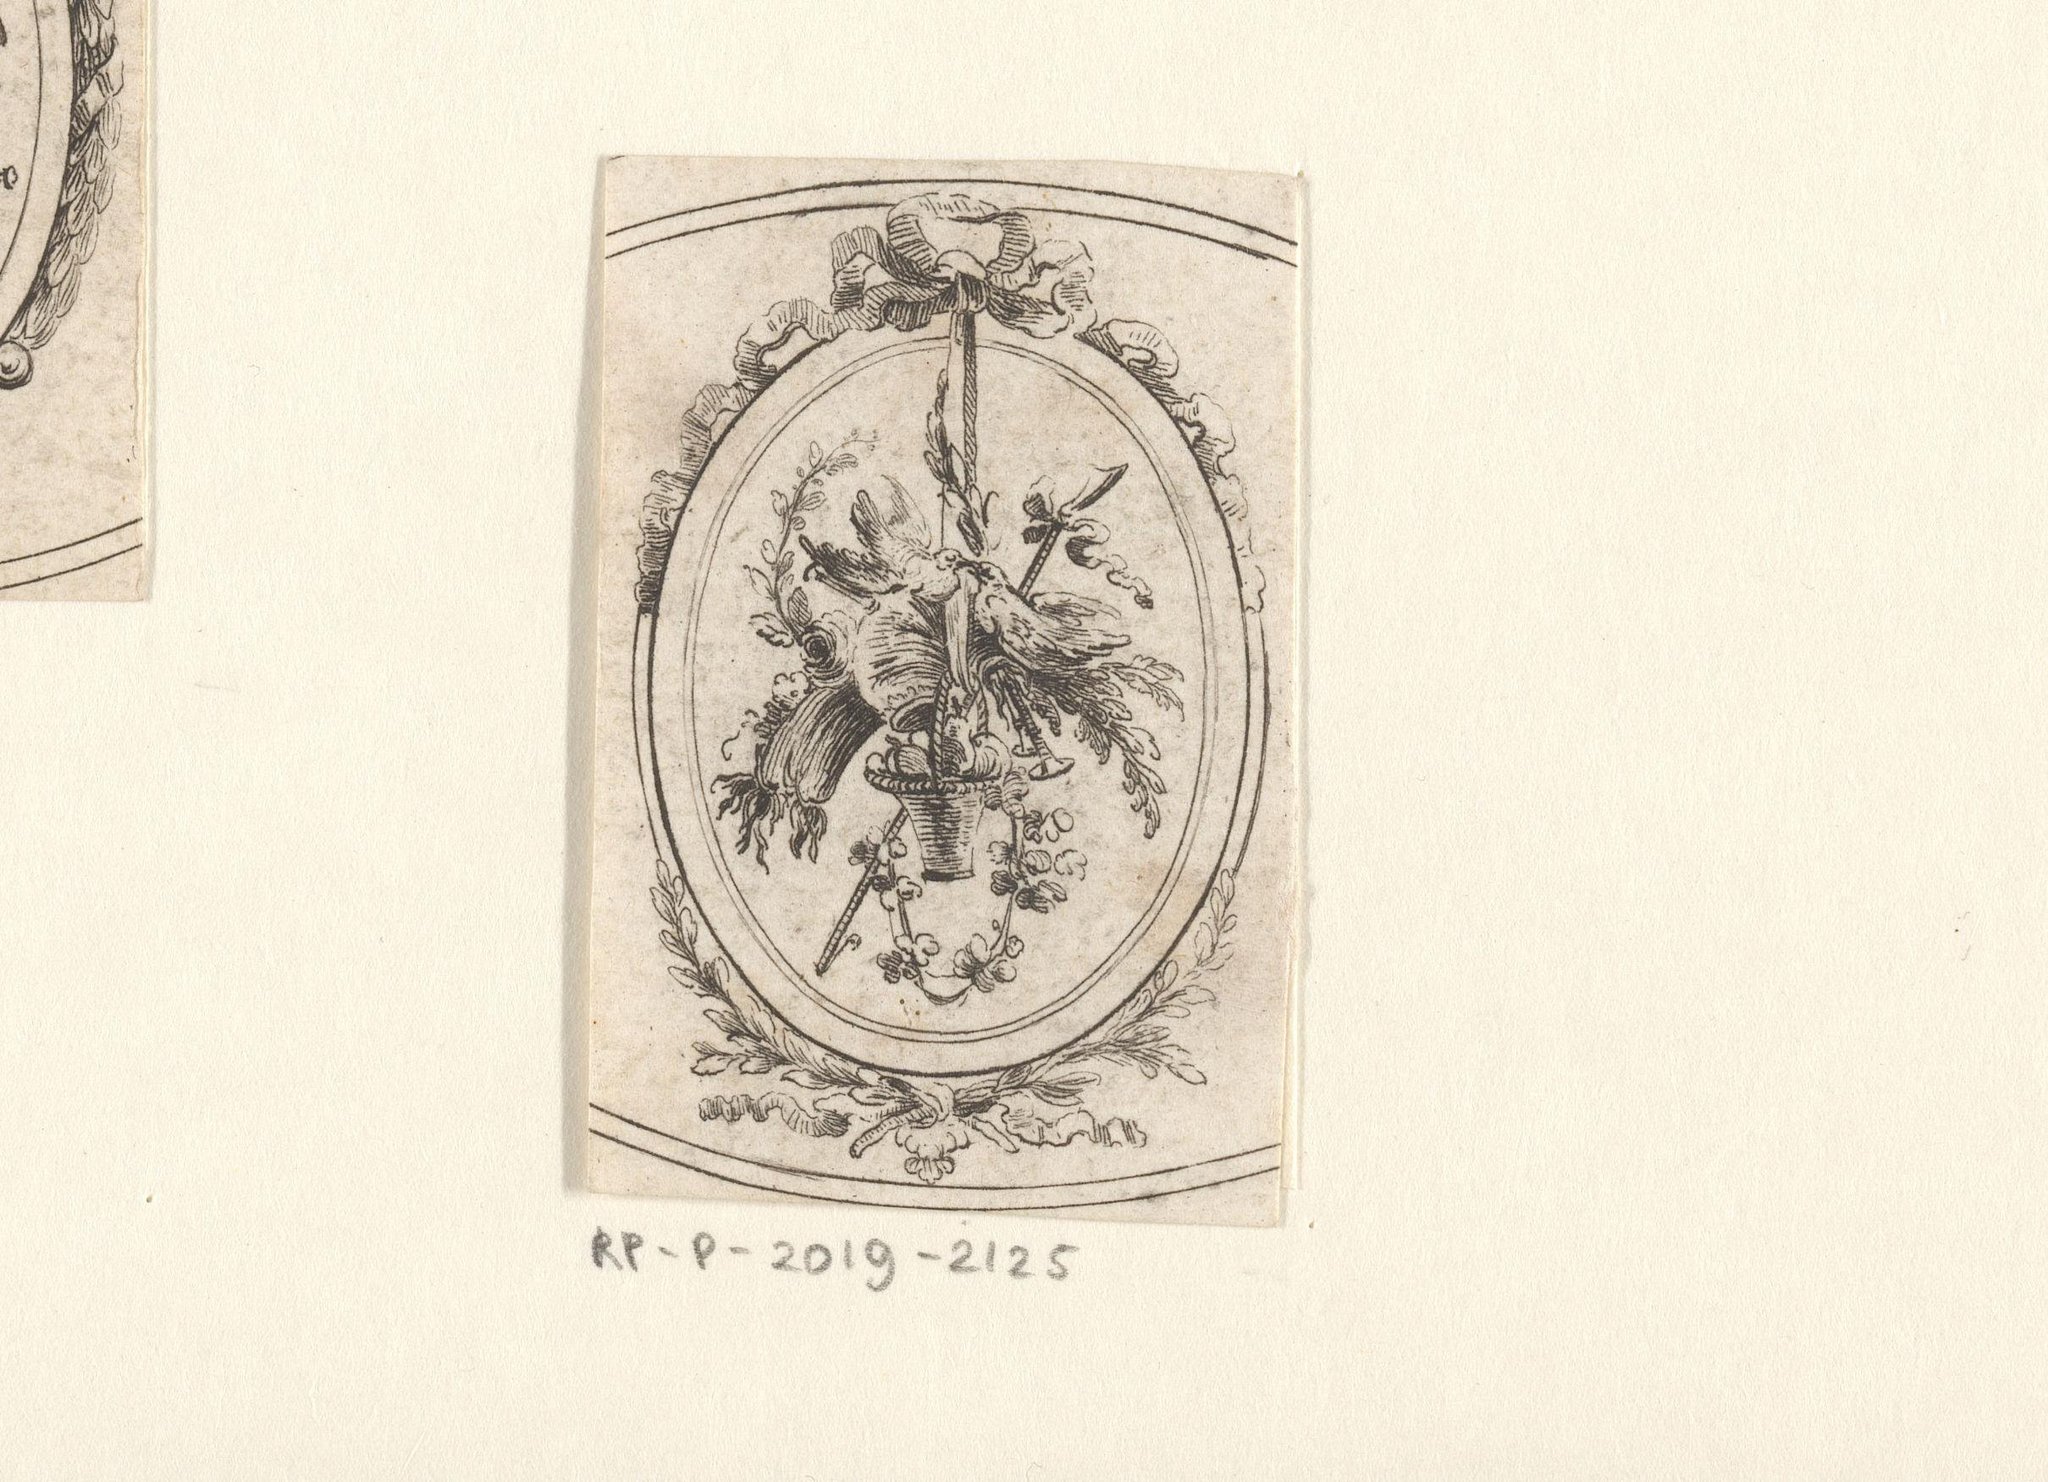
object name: print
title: Vignet met een cartouche met twee duiven boven een mand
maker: Anonymous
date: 1650-1799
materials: paper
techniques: etching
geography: netherlands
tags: other birds: dove, container made of plant material other than wood: basket, ornament ~ cartouche, illustration ~ printed matter, book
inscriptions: collector's mark: Lugt 2228